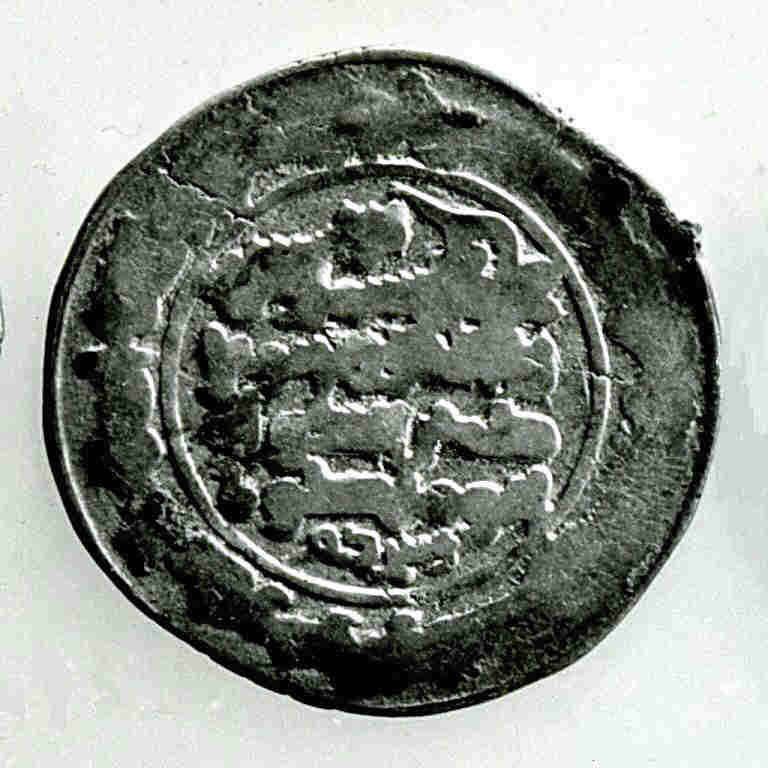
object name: coin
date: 967-978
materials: silver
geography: amul